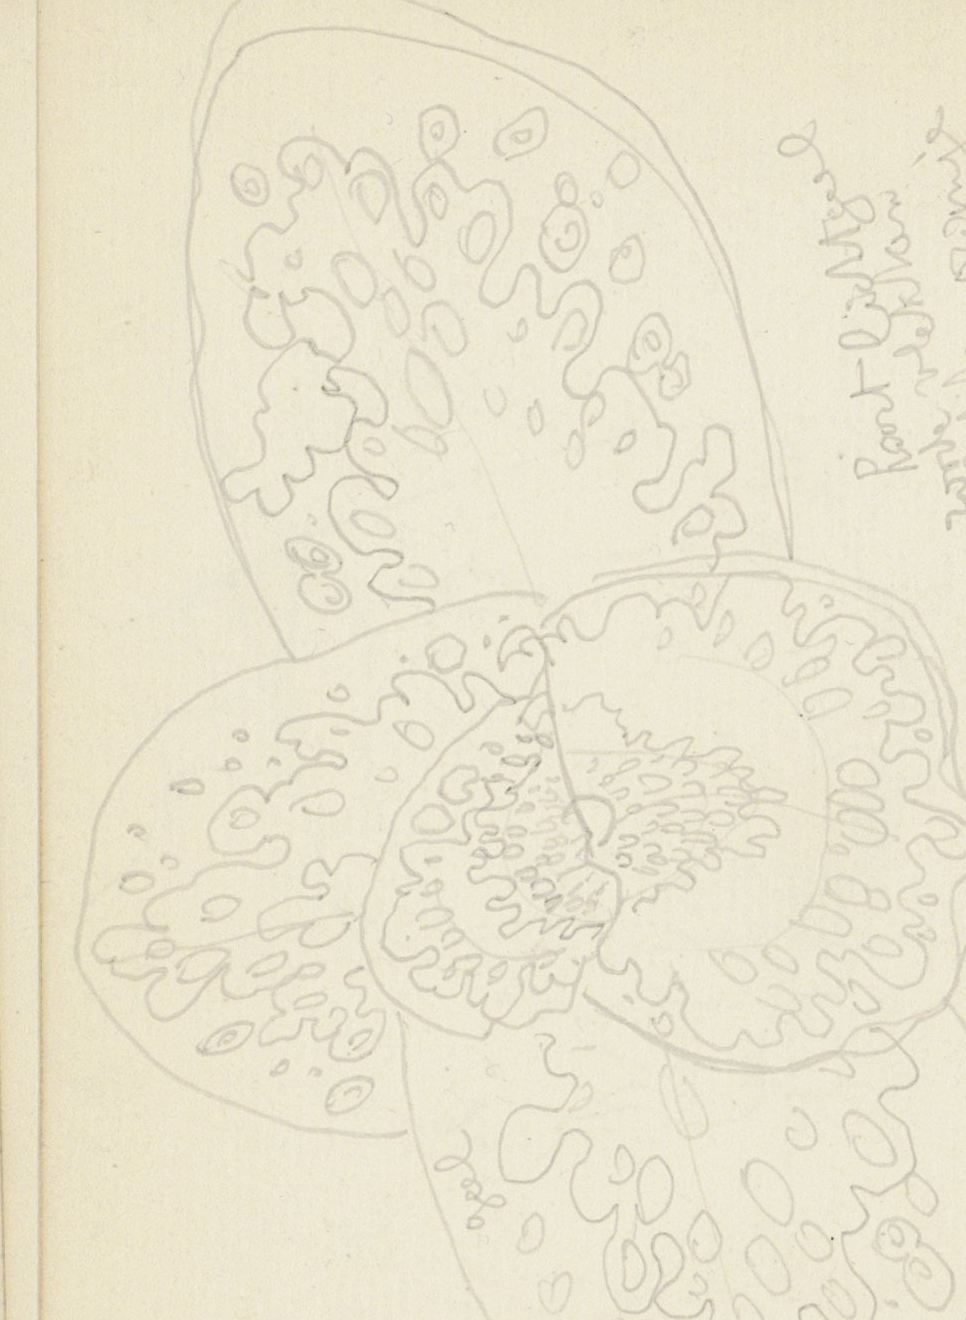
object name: sketchbook leaf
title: Bloem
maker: reijer stolk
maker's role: draughtsman, print maker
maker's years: 1896-1945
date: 1916-1945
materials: paper, pencil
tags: flowers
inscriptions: annotation: ‘hart lichtgeel/ roode vlekken/ groote vlekken oranje/ met roode vlekken’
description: Blad 17 verso uit een schetsboek met 60 bladen.